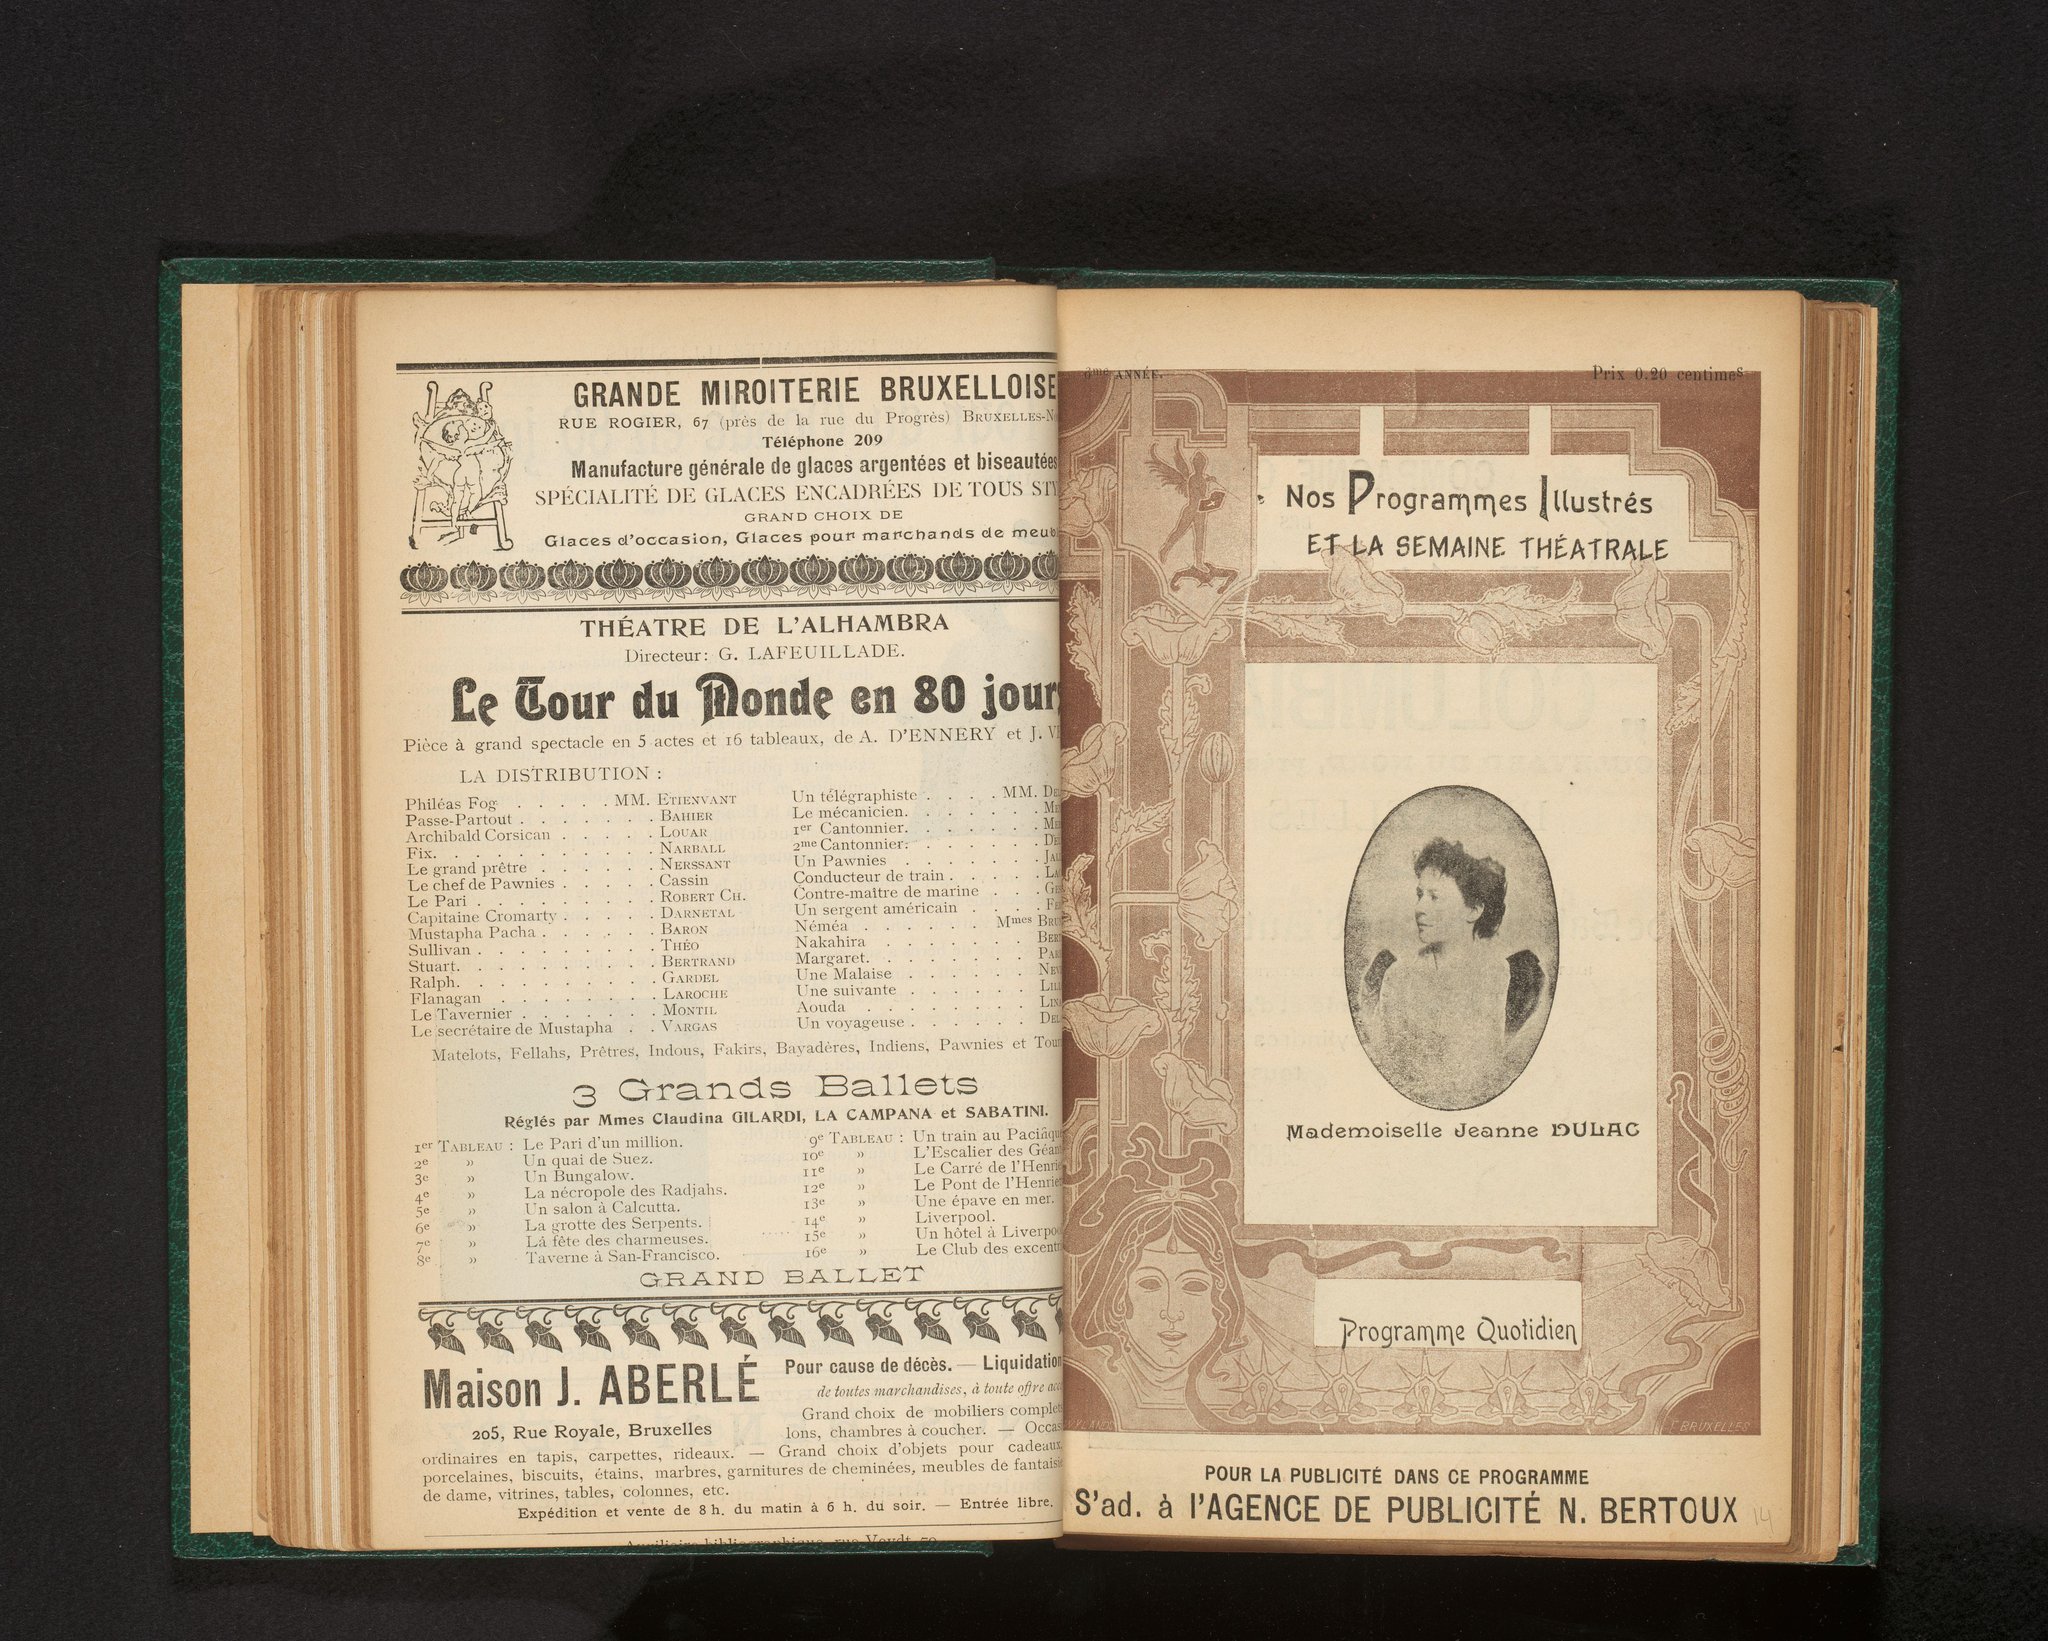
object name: page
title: Portret van Jeanne Dulac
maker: Anonymous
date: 1895-1900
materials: paper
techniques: autotype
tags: adult man, historical persons